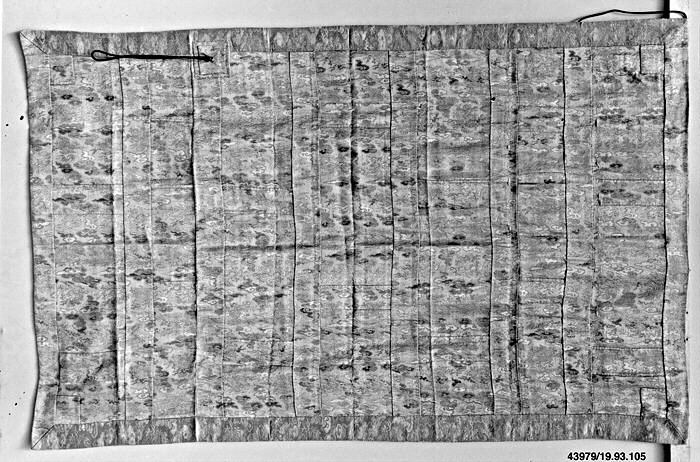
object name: robe, priest's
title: Priest's Robe (Shichijō)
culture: japanese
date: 1600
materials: metal thread, silk